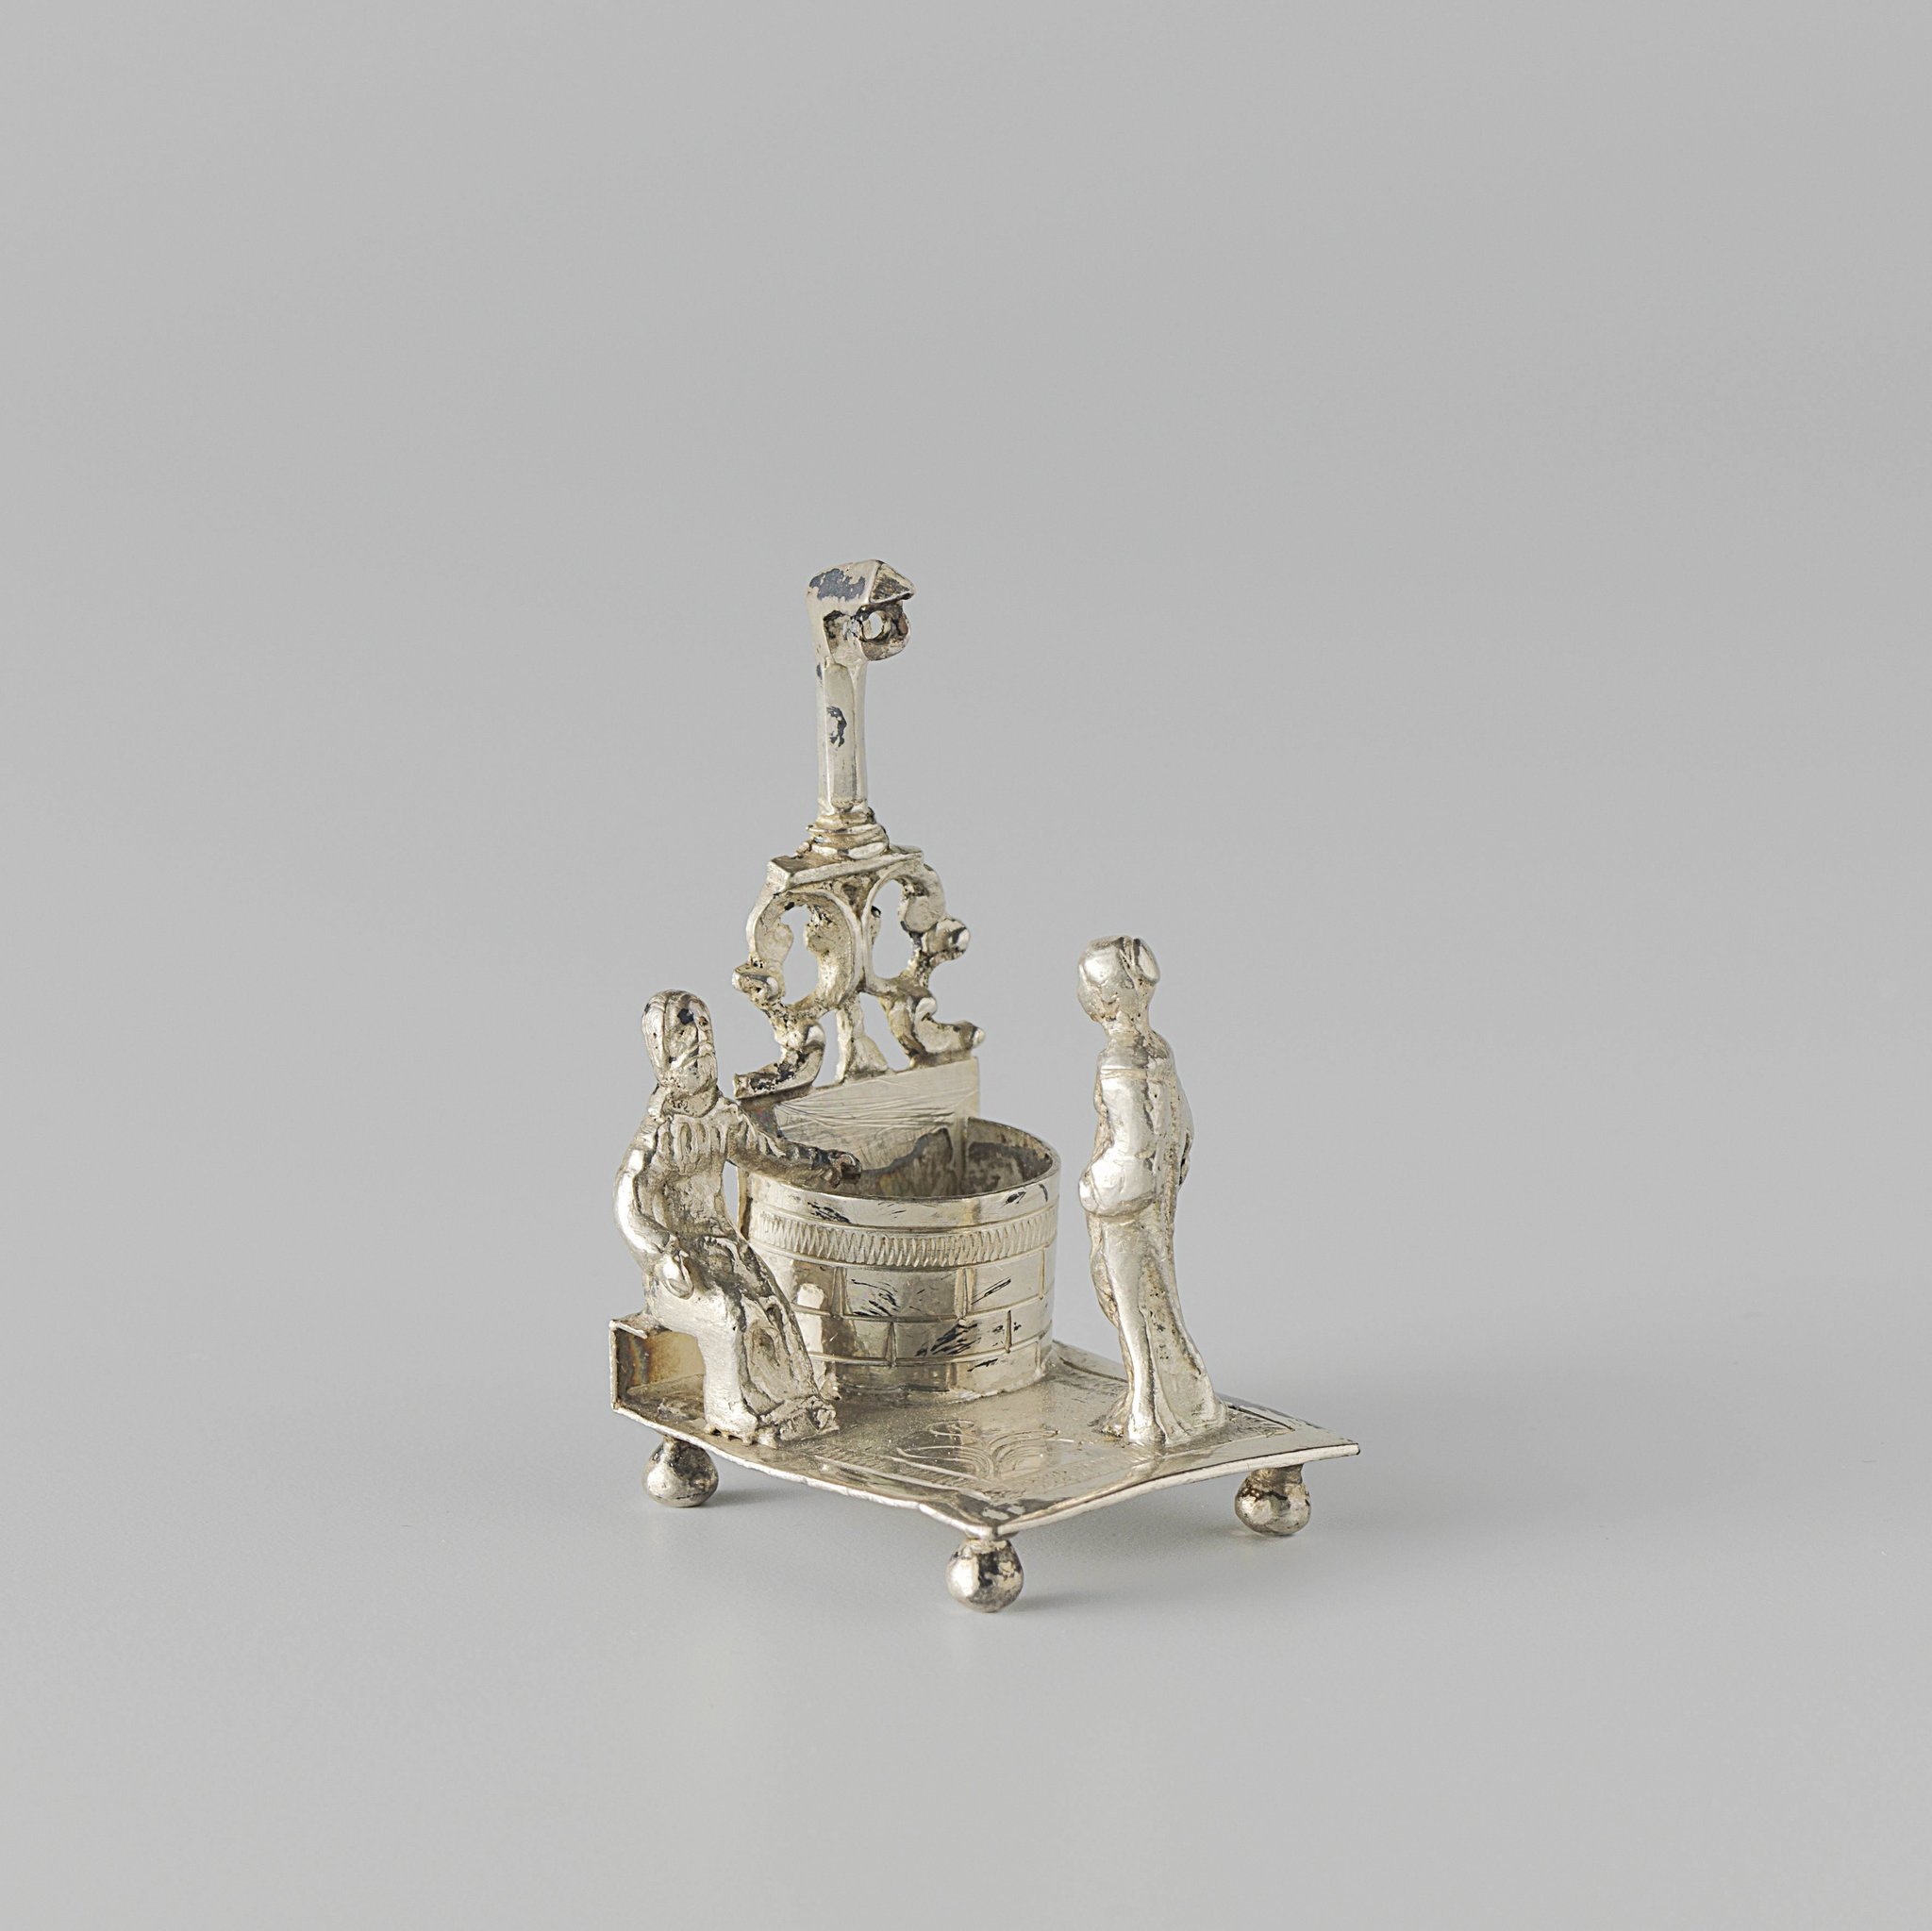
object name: miniature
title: Christus en de Samaritaanse vrouw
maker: Anonymous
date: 1600-1700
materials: silver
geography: netherlands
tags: christ and the woman of samaria: sitting at jacob's well he asks her for a drink from her jug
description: Op een rechthoekige plaat staat een halfronde, cilindrische waterput. Naast de put zit een man met baard. Zijn linkerhand ligt op de rand van de put. Tegenover de man staat een vrouw. Het beeld stelt Christus voor met de Samaritaanse vrouw. De plaat staat op vier bolpoten, heeft een gegraveerde zig-zag lijn langs de rand en heeft gegraveerde bladeren in een hoek. Het beeld is gemerkt met een onleesbaar merk.